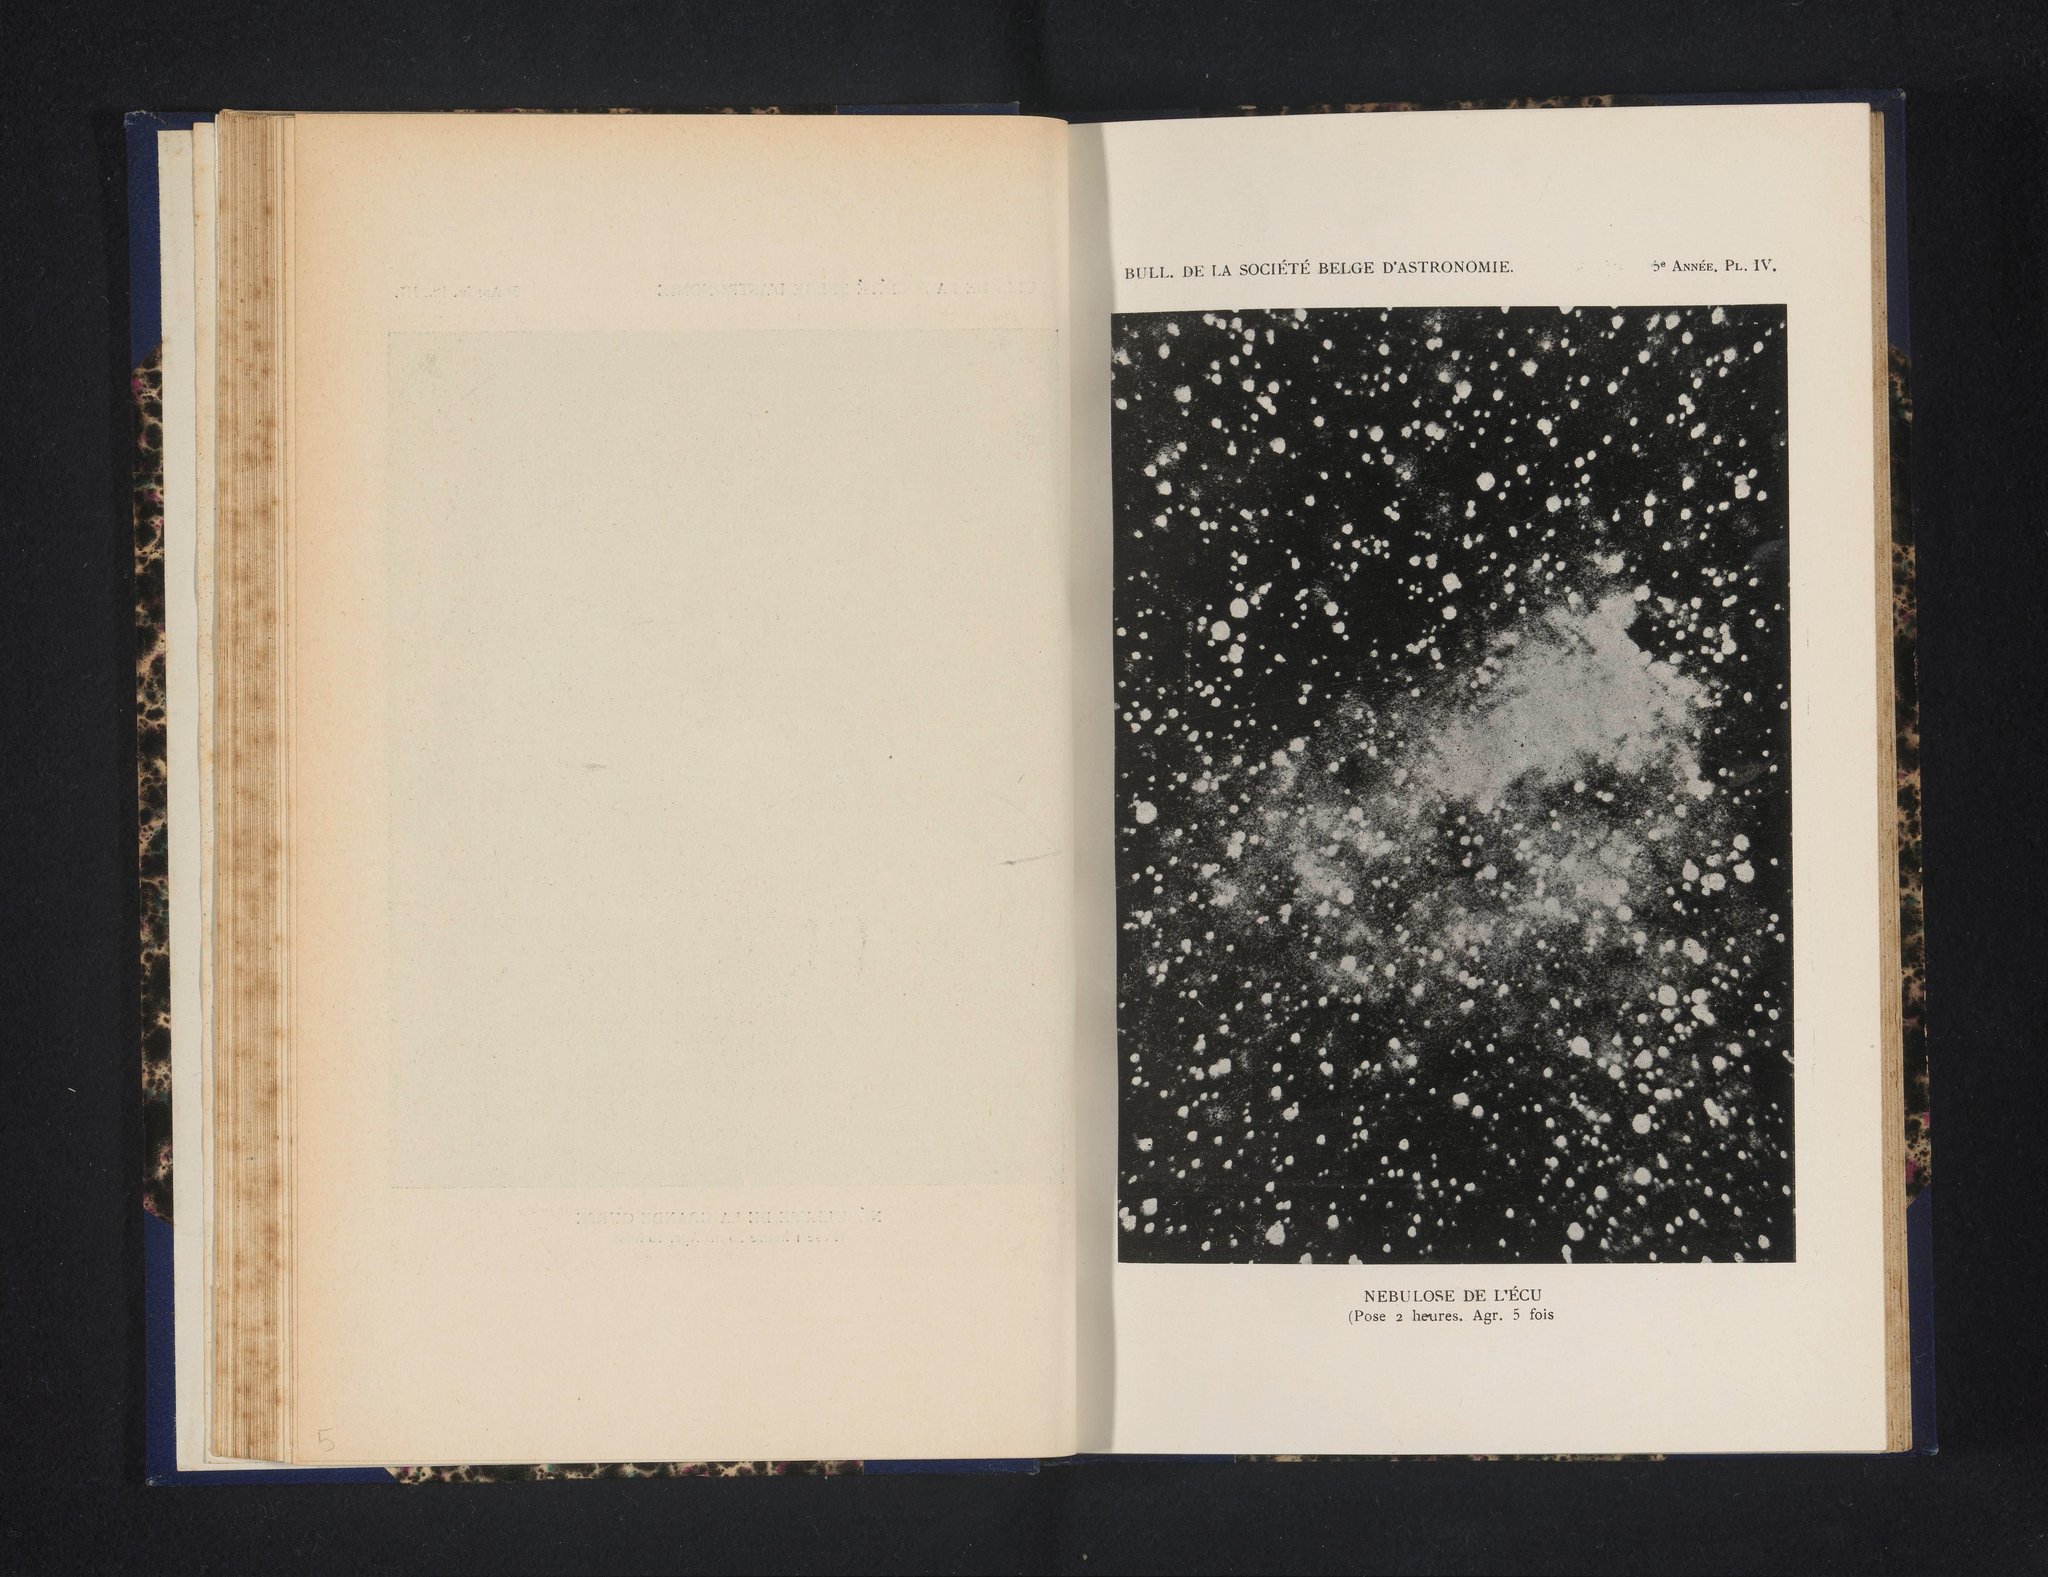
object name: page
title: Nevel bij een sterrenbeeld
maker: Anonymous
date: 1895-1900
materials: paper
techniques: autotype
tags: stars and constellations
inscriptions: inscription: ‘Pose 2 heures Agr. 5 fois.’, inscription: ‘Société Belge D'Astronomie 5e Année, Pl. IV’